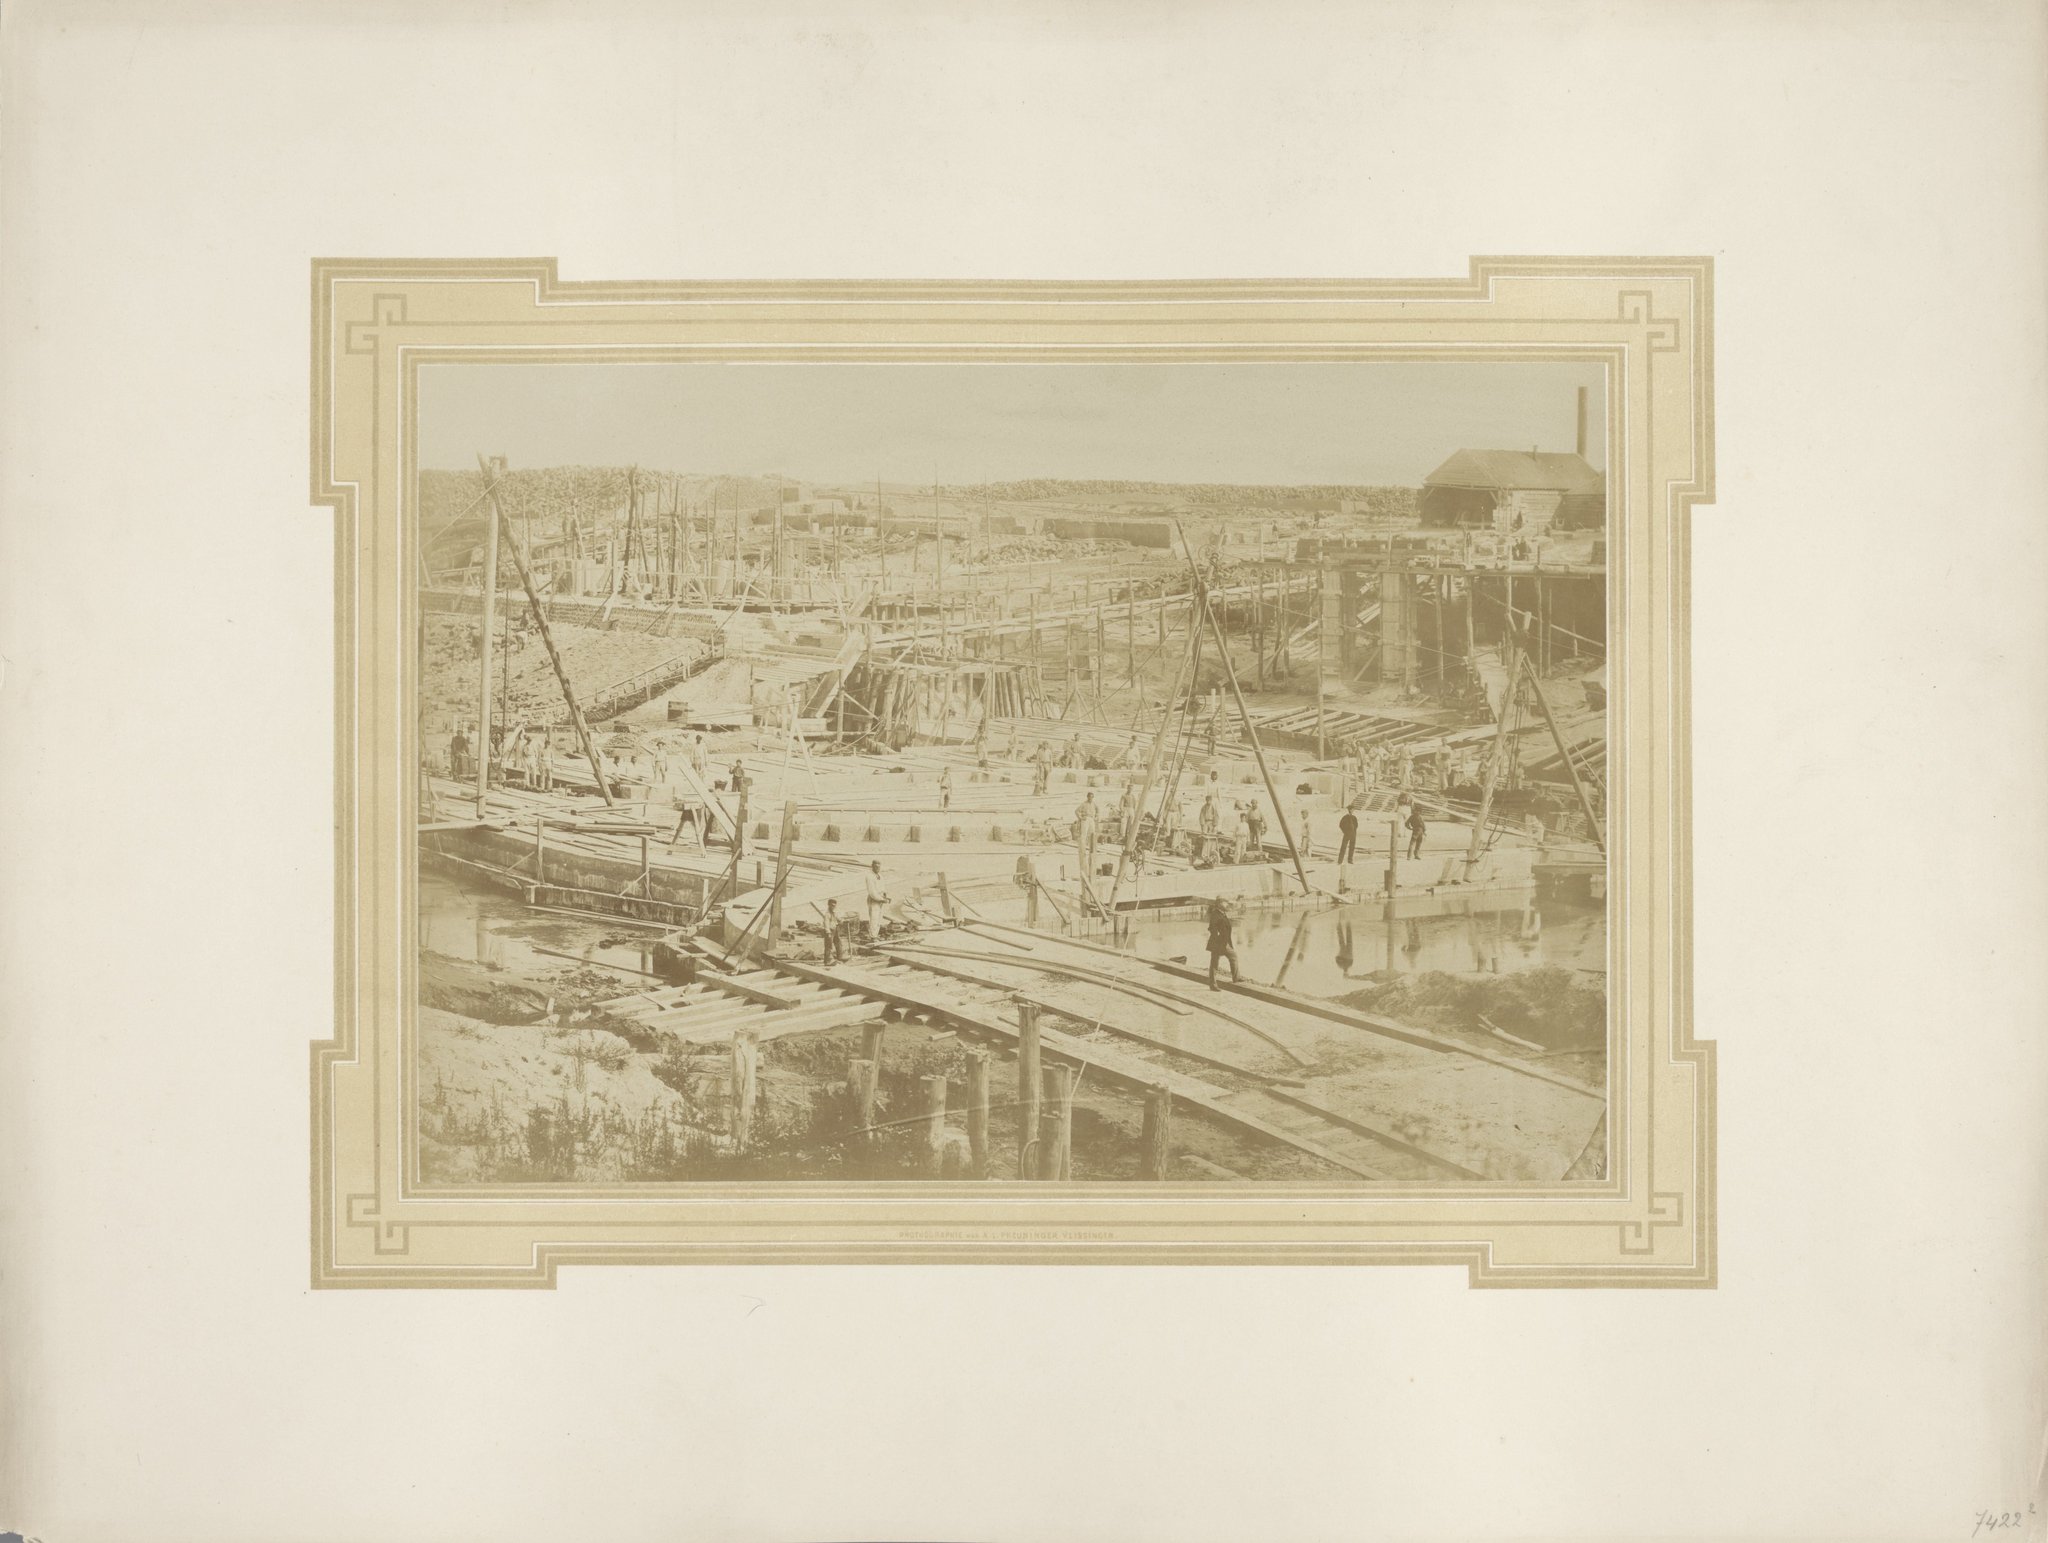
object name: photograph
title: Aanleg (betonstorting) van de dubbele schutsluis te Vlissingen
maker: anton lauwrens preuninger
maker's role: fotograaf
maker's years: 1846-1919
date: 1807-1869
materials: cardboard, paper, photographic support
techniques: albumen print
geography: flushing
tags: sluice, weir, canal, building-site, flushing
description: Betonstorting tijdens de aanleg van de dubbele schutsluis te Vlissingen, juli 1869. Onderdeel van een serie van veertien foto's van deze bouwprojecten in Zeeland.